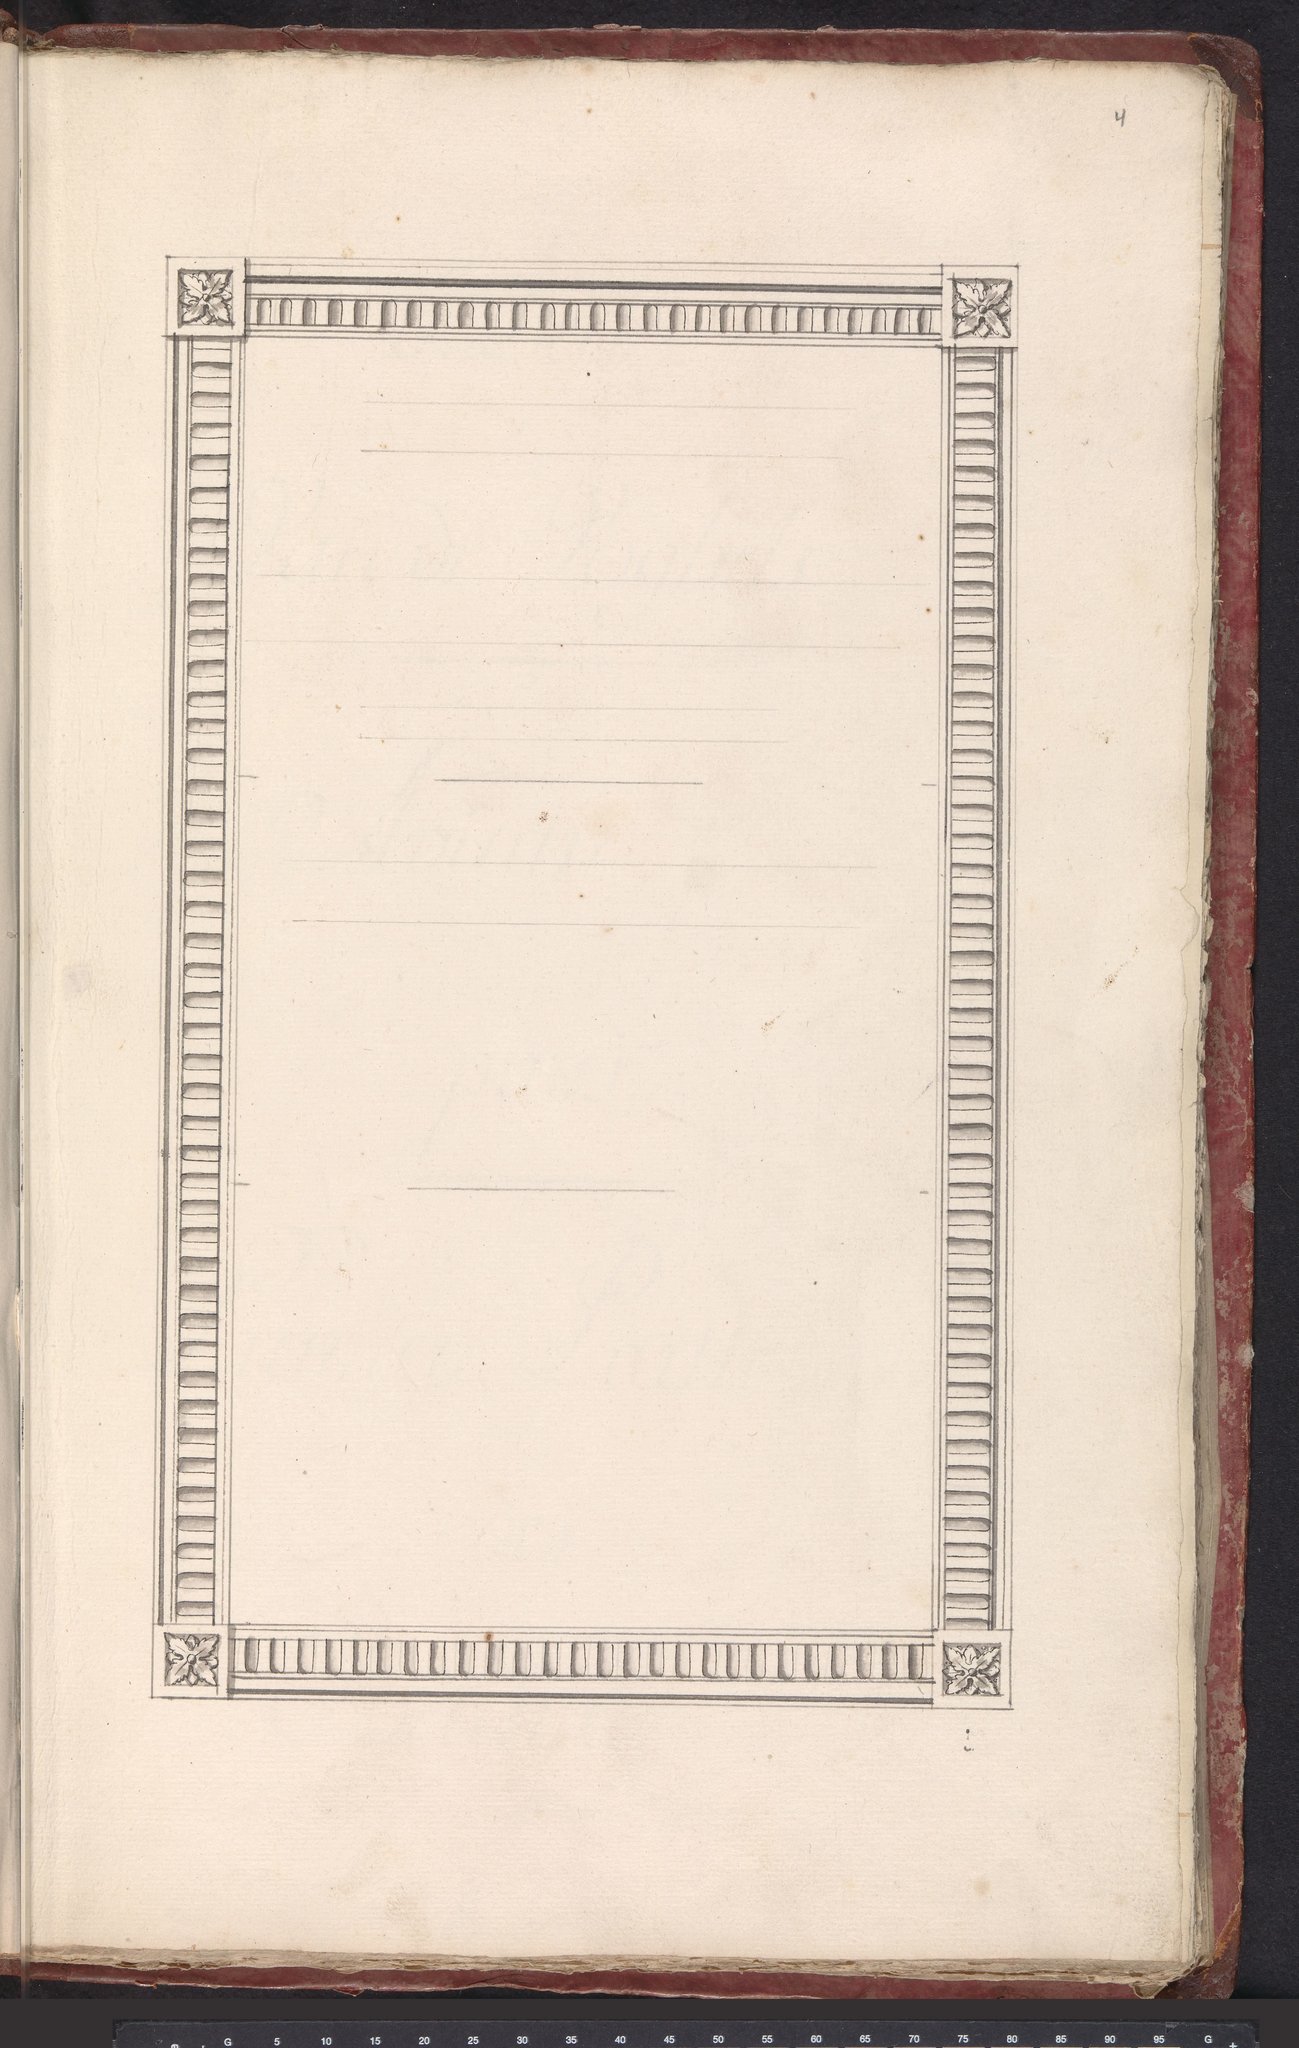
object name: drawing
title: Omlijsting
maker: Anonymous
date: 1809-1814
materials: ink, paper, pencil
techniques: brush, pen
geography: southern netherlands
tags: frame of painting, etc.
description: Lege omlijsting. Onderdeel van het eerste album met tekeningen van vogels. Tweede van twaalf albums met tekeningen van dieren, vogels en planten bekend rond 1600, gemaakt in opdracht van keizer Rudolf II. Met toelichting in Nederlands, Latijn en Frans.